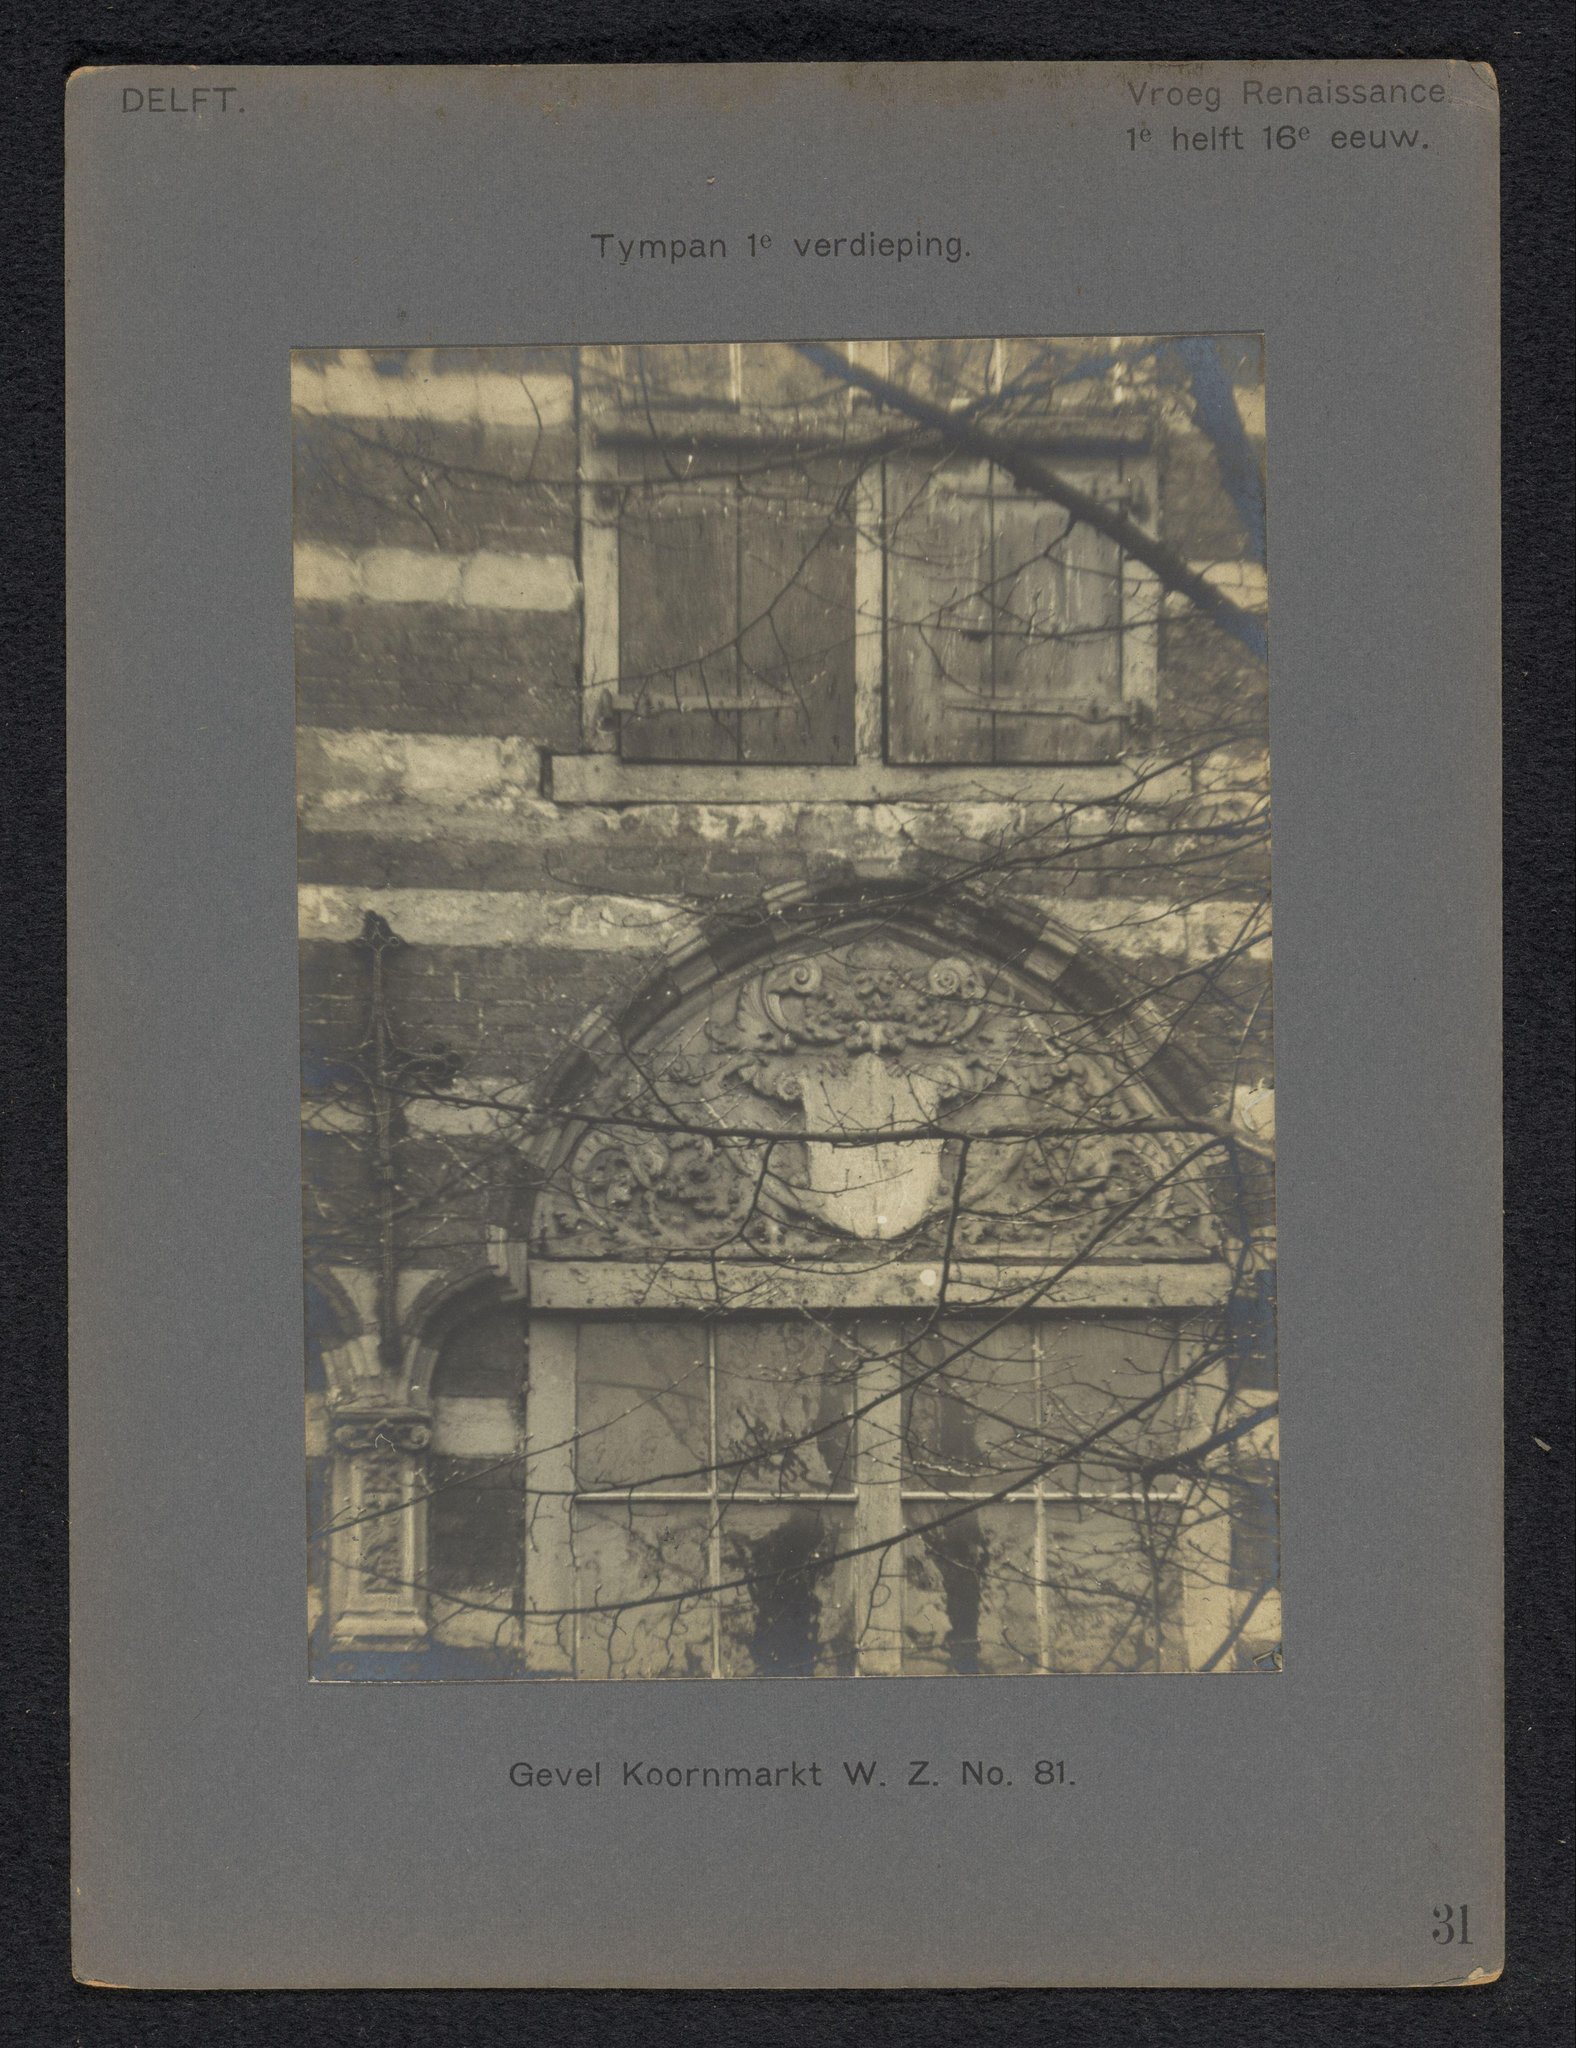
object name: photograph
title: Timpaan op de gevel van een huis aan de Koornmarkt in Delft, gedecoreerd met een wapenschild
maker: Anonymous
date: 1900-1904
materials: cardboard, photographic support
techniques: gelatin silver print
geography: delft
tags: urban housing, ornament derived from architectural details, ornament derived from plant forms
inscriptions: inscription: ‘Het recht van reproductie dezer photo's wordt door den Uitgever voorbehouden.’, number: ‘31’, inscription: ‘Delft. Vroeg Renaissance. 1e helft 16e eeuw.’